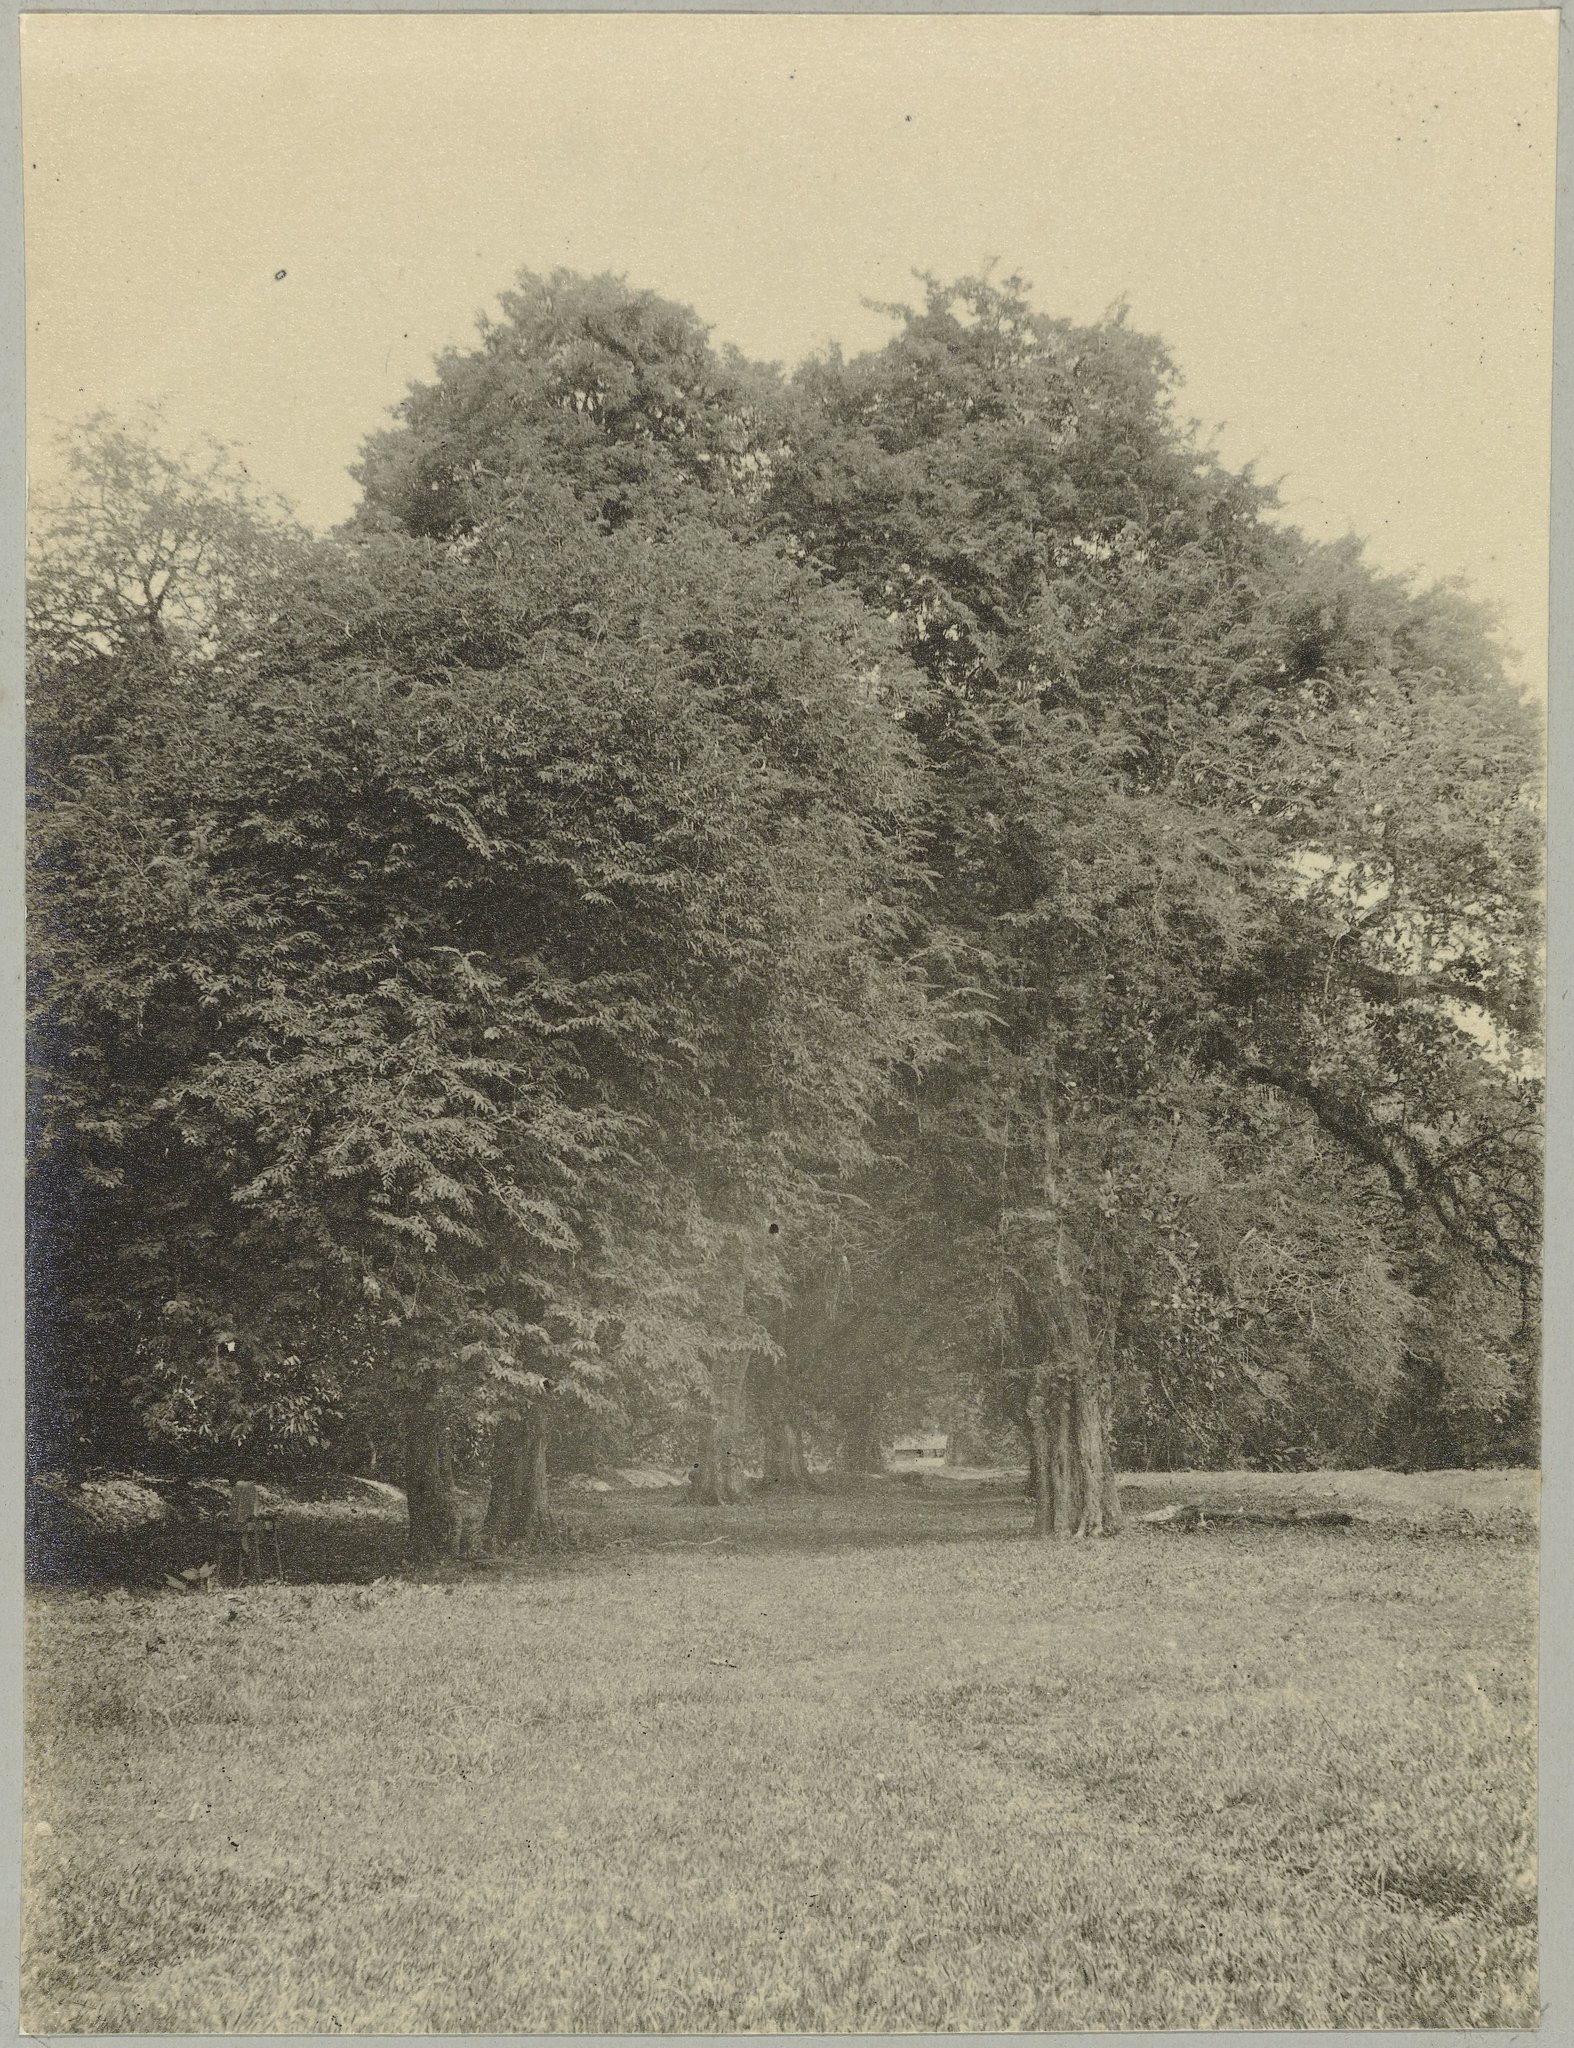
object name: photograph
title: Tamarindegroepen op Tourtonne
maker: hendrik doijer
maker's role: engineer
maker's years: 1863-1925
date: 1903-1910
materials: photographic support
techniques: gelatin silver print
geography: suriname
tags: suriname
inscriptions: inscription: ‘C11 / Tamarindegroepen op Tourtonne.’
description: Groepen hoge tamarindebomen op de plantage Tourtonne. Onderdeel van het fotoalbum Souvenir de Voyage (deel 2), over het leven van de familie Doijer in en rond de plantage Ma Retraite in Suriname in de jaren 1903-1910.